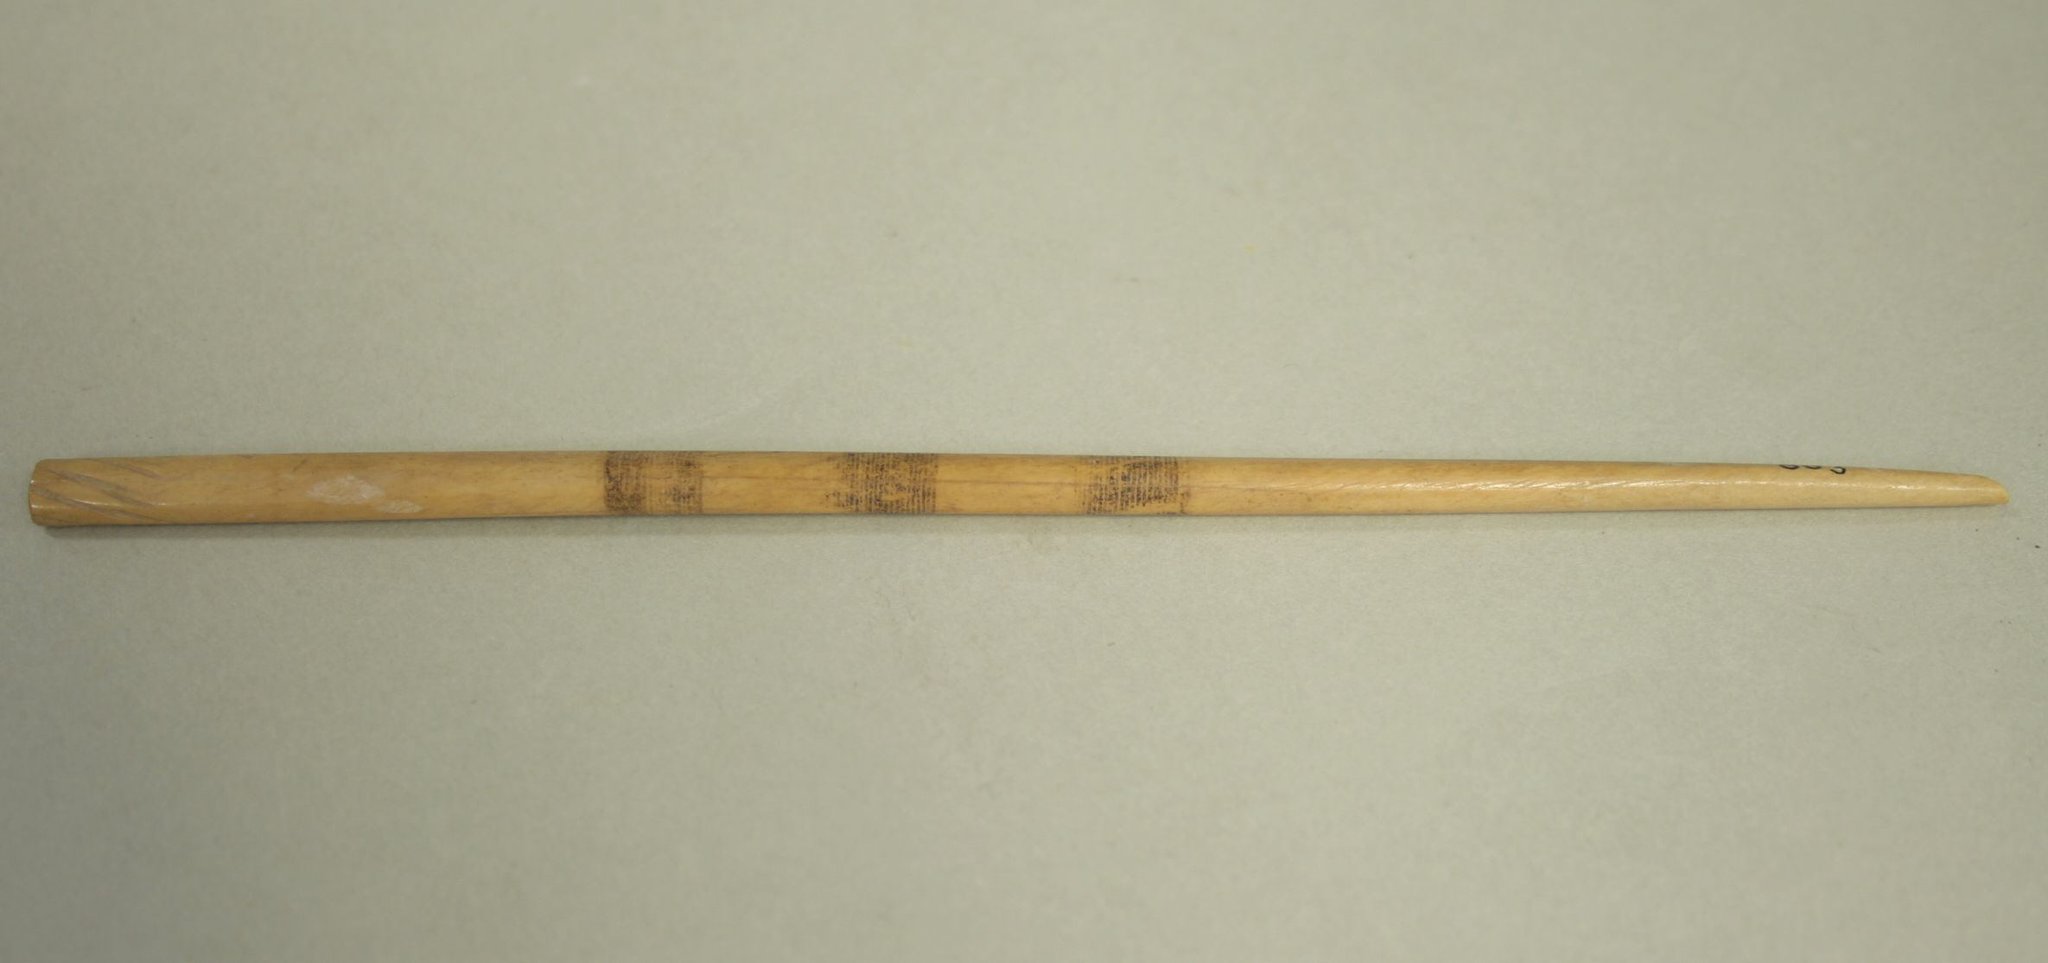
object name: bobbin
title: Bone Weaving Bobbin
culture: peruvian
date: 701-1566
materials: bone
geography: peru